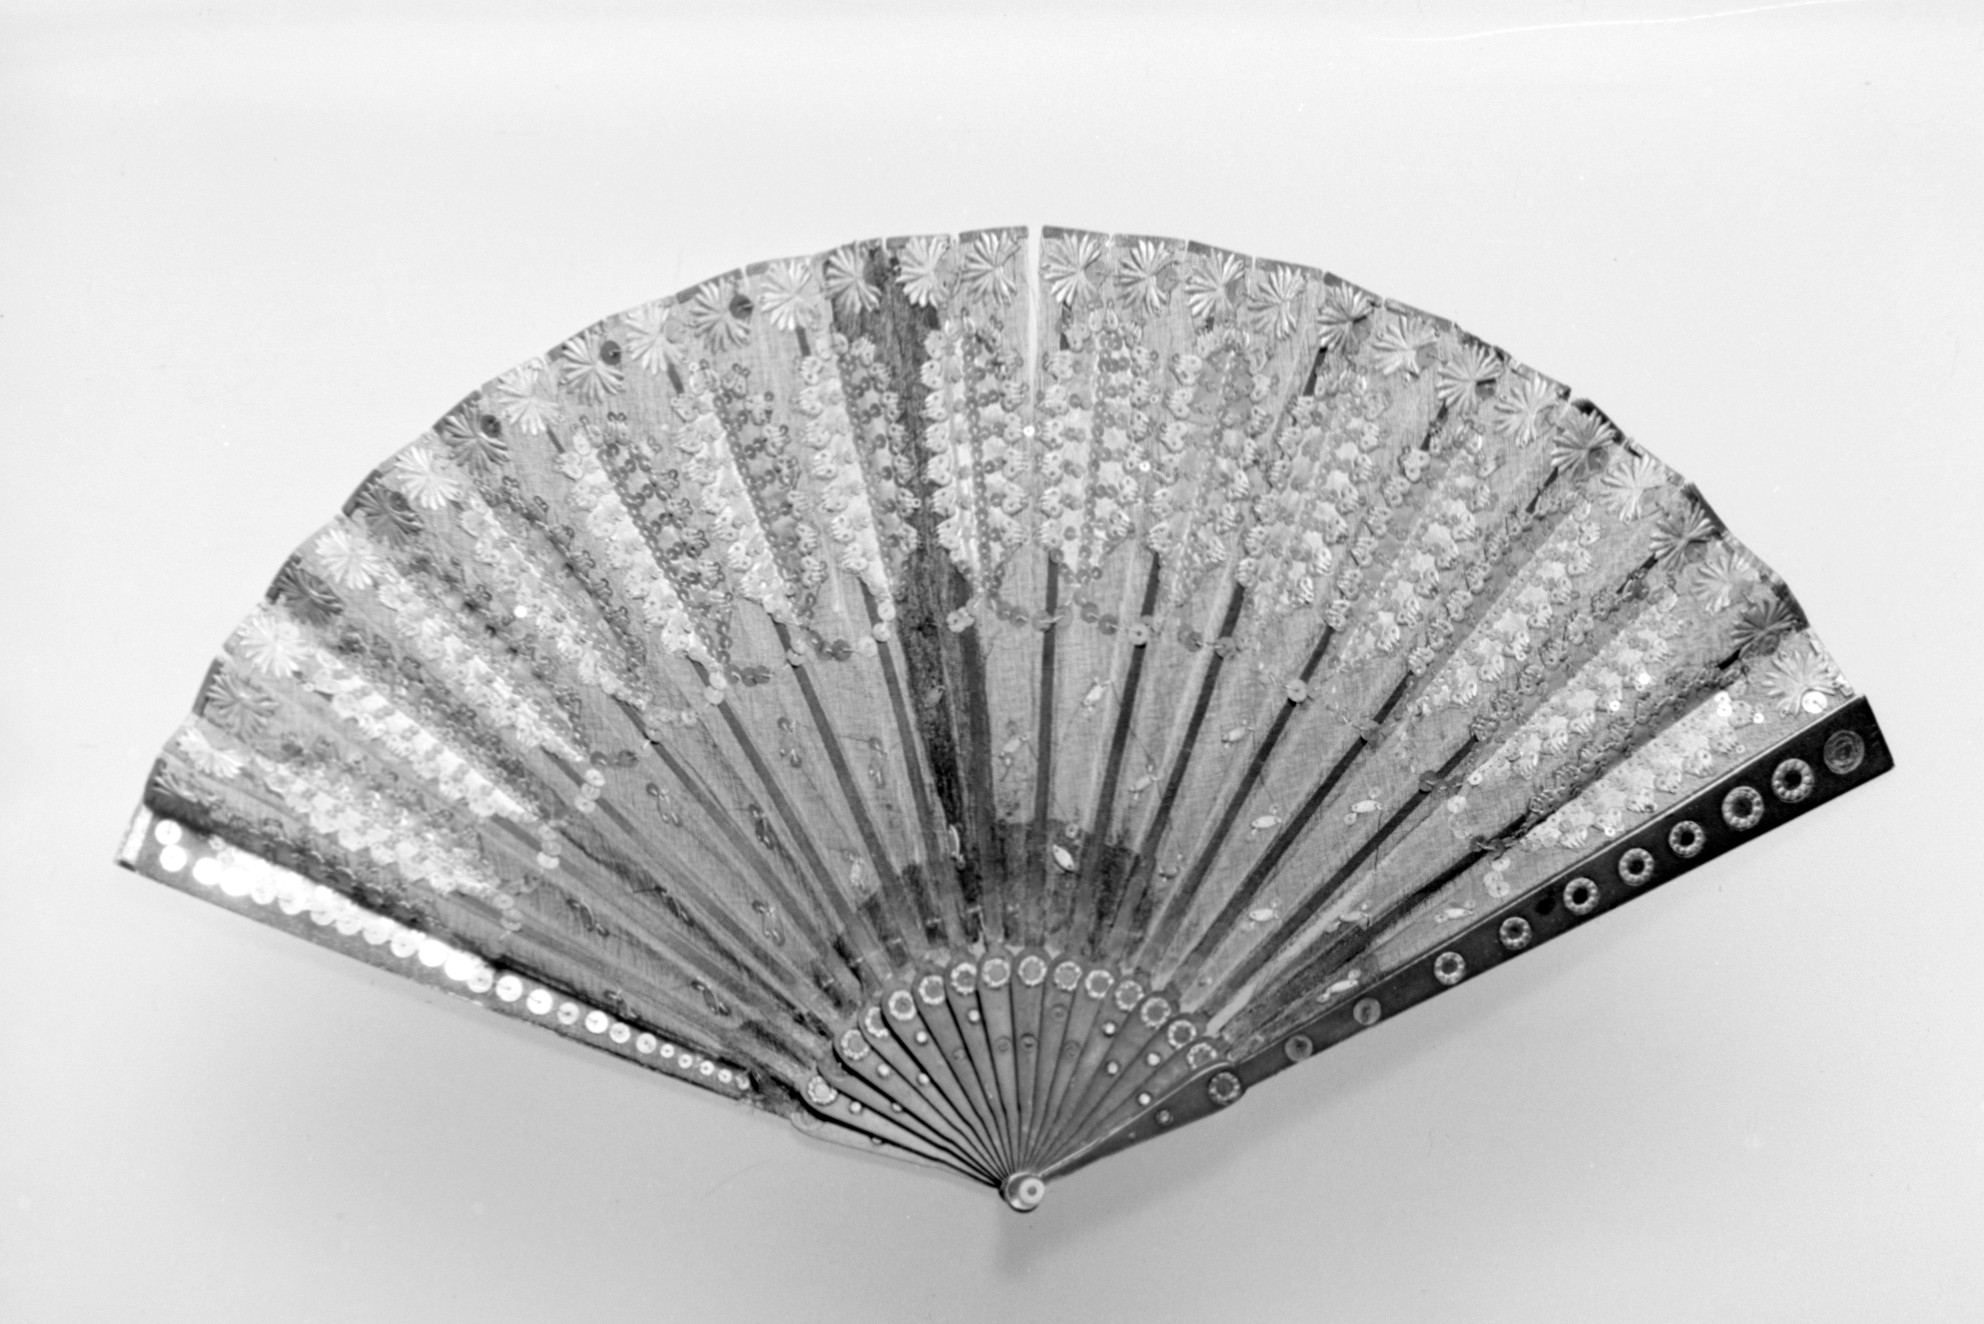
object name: fan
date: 1800-1833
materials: ivory, metal, paper, silk